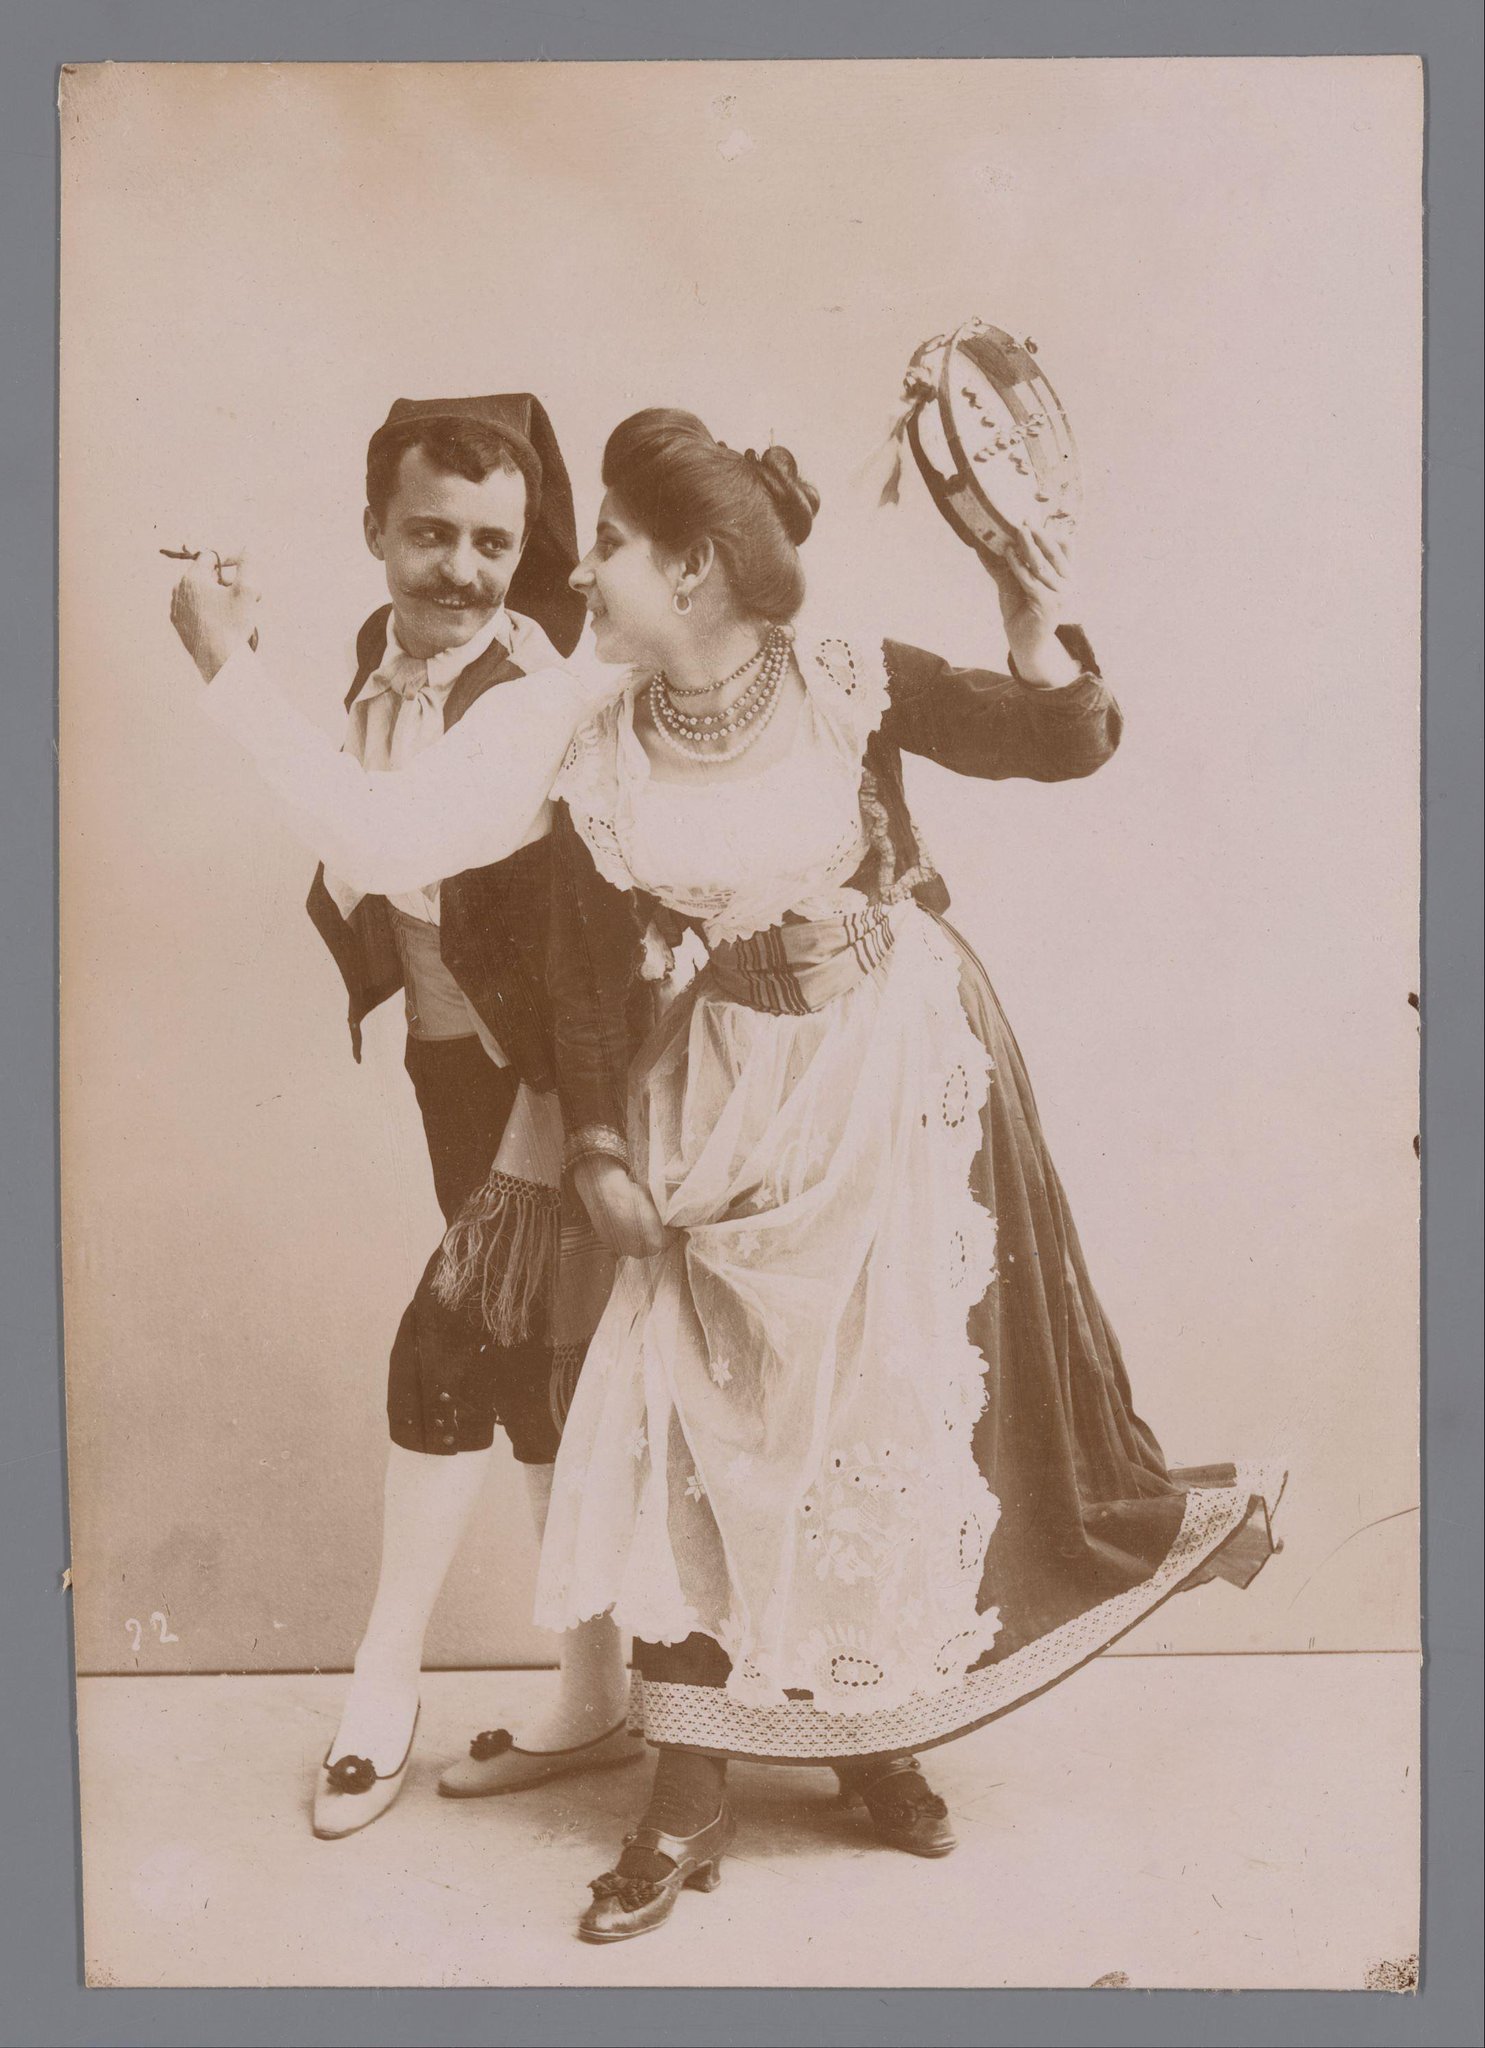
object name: photograph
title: Man en vrouw dansen de tarantella in Hotel Tramontana te Sorrento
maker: Anonymous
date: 1851-1900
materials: paper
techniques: gelatin silver print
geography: sorrento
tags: one pair dancing; man and woman dancing as a couple, sorrento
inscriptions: number: ‘72.’, inscription: ‘Tarentalla in Hôtel Tramontano/ 29 april./ Sorrento’